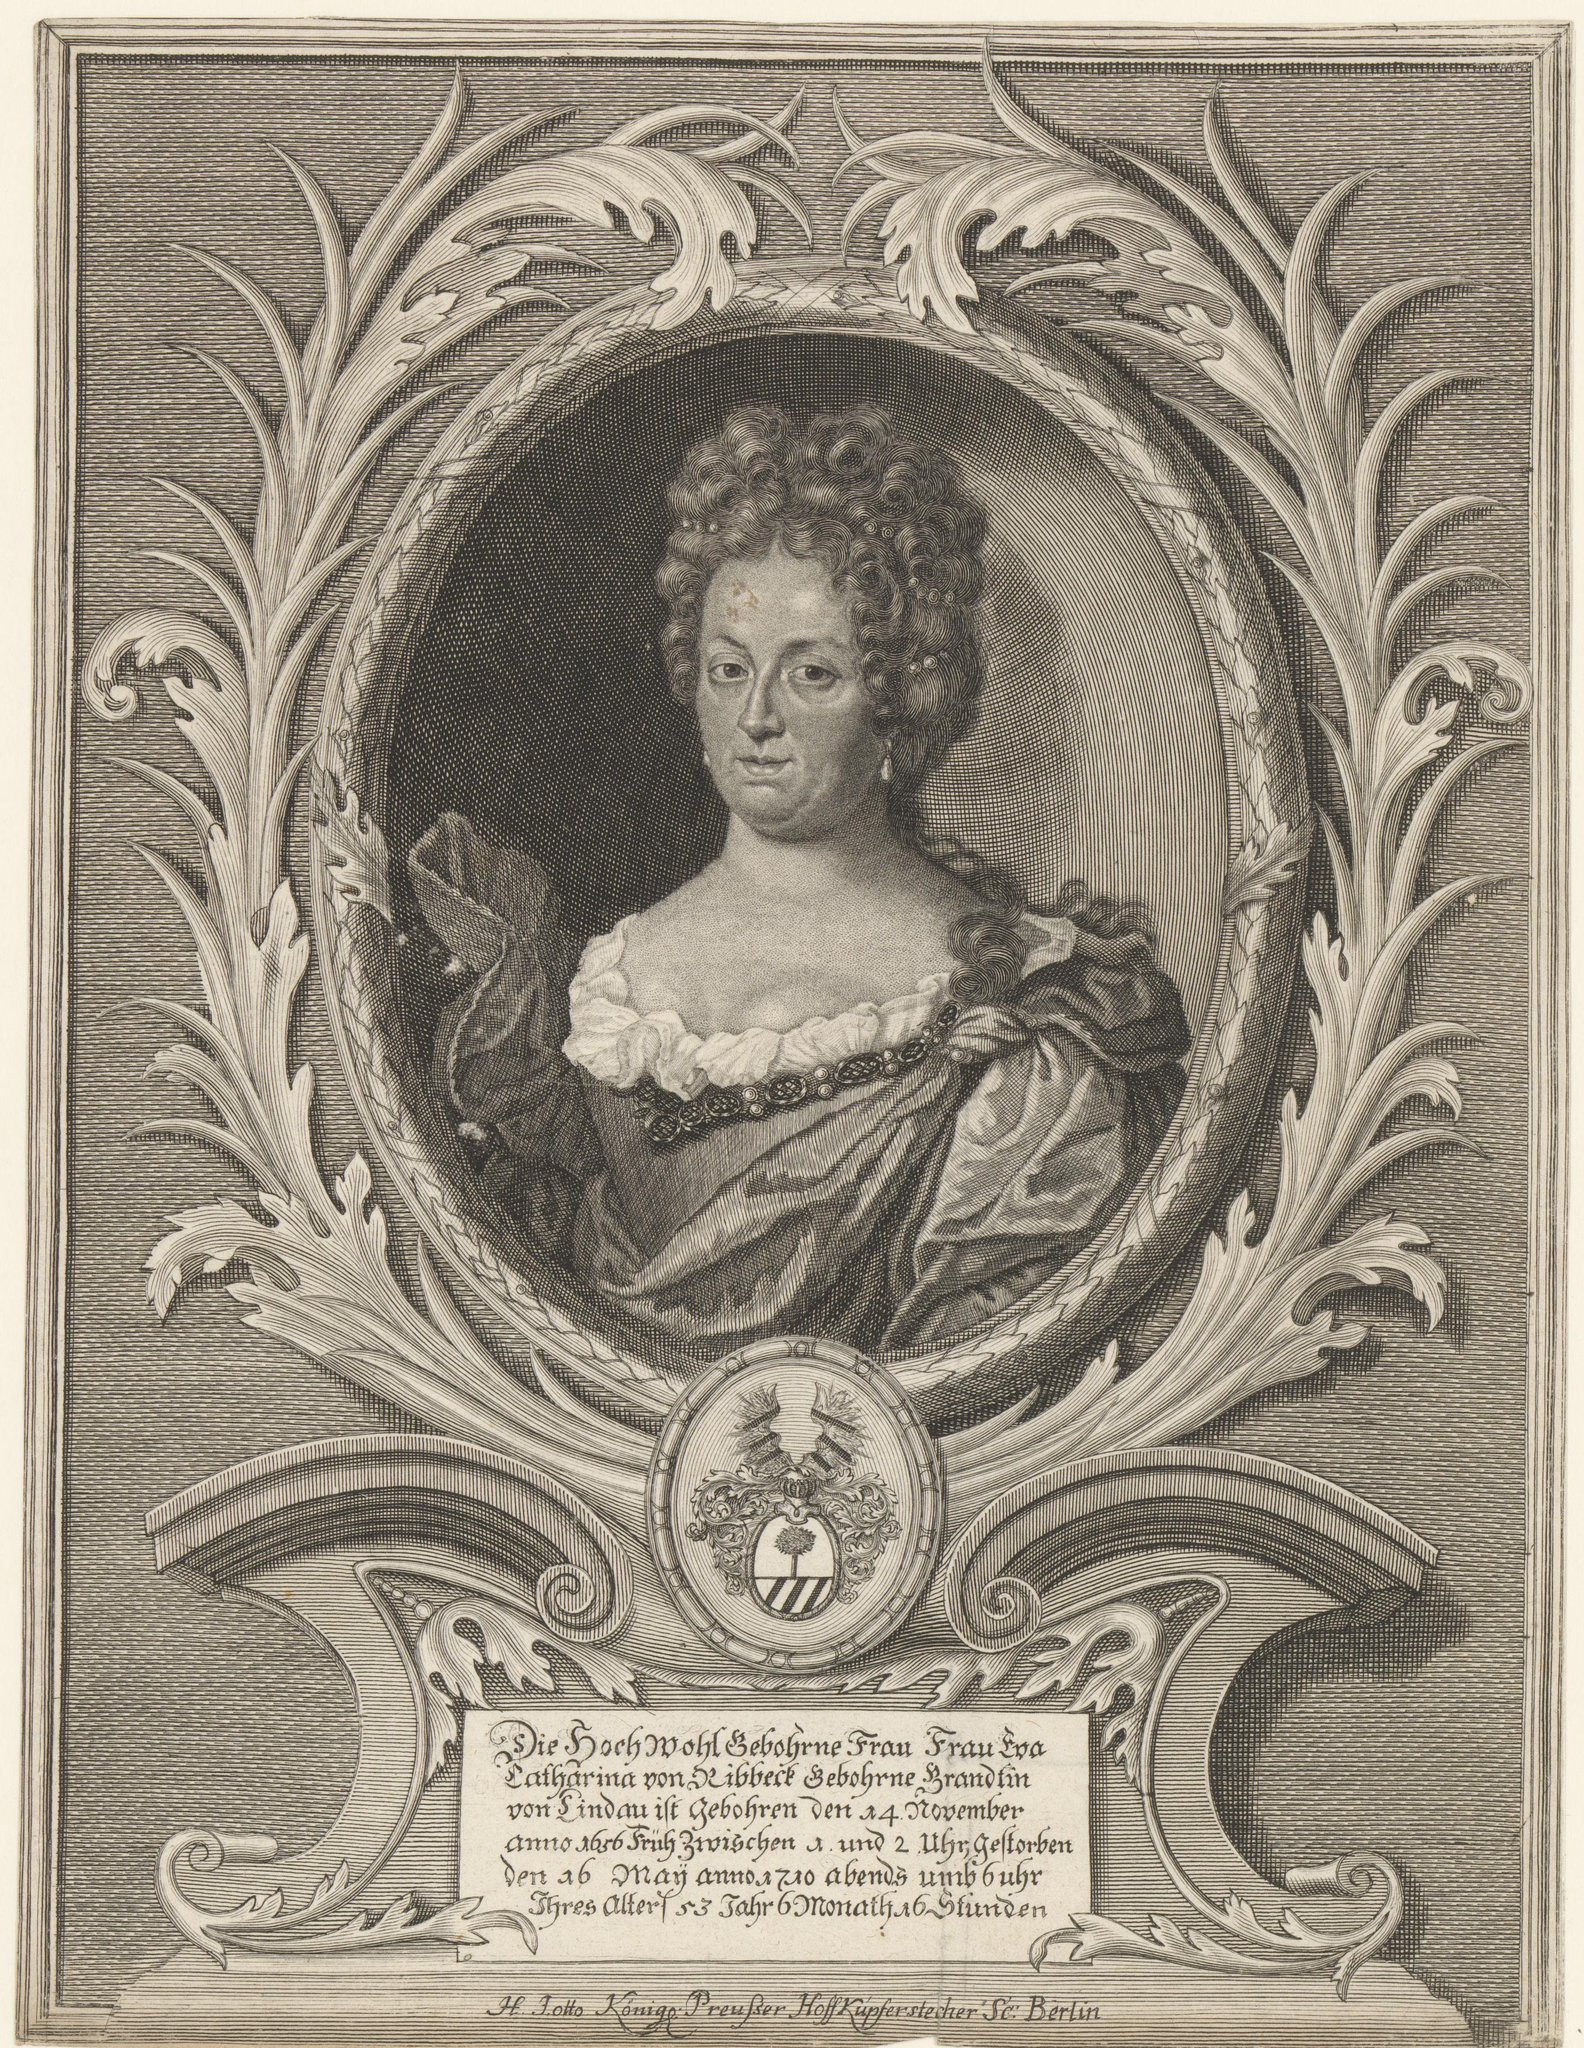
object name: print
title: Portret van Eva Catharina von Ribbeck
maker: heinrich jakob otto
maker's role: print maker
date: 1671-1749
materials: paper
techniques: engraving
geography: berlin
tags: historical persons - bb - woman, armorial bearing, heraldry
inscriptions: collector's mark: Lugt 2228